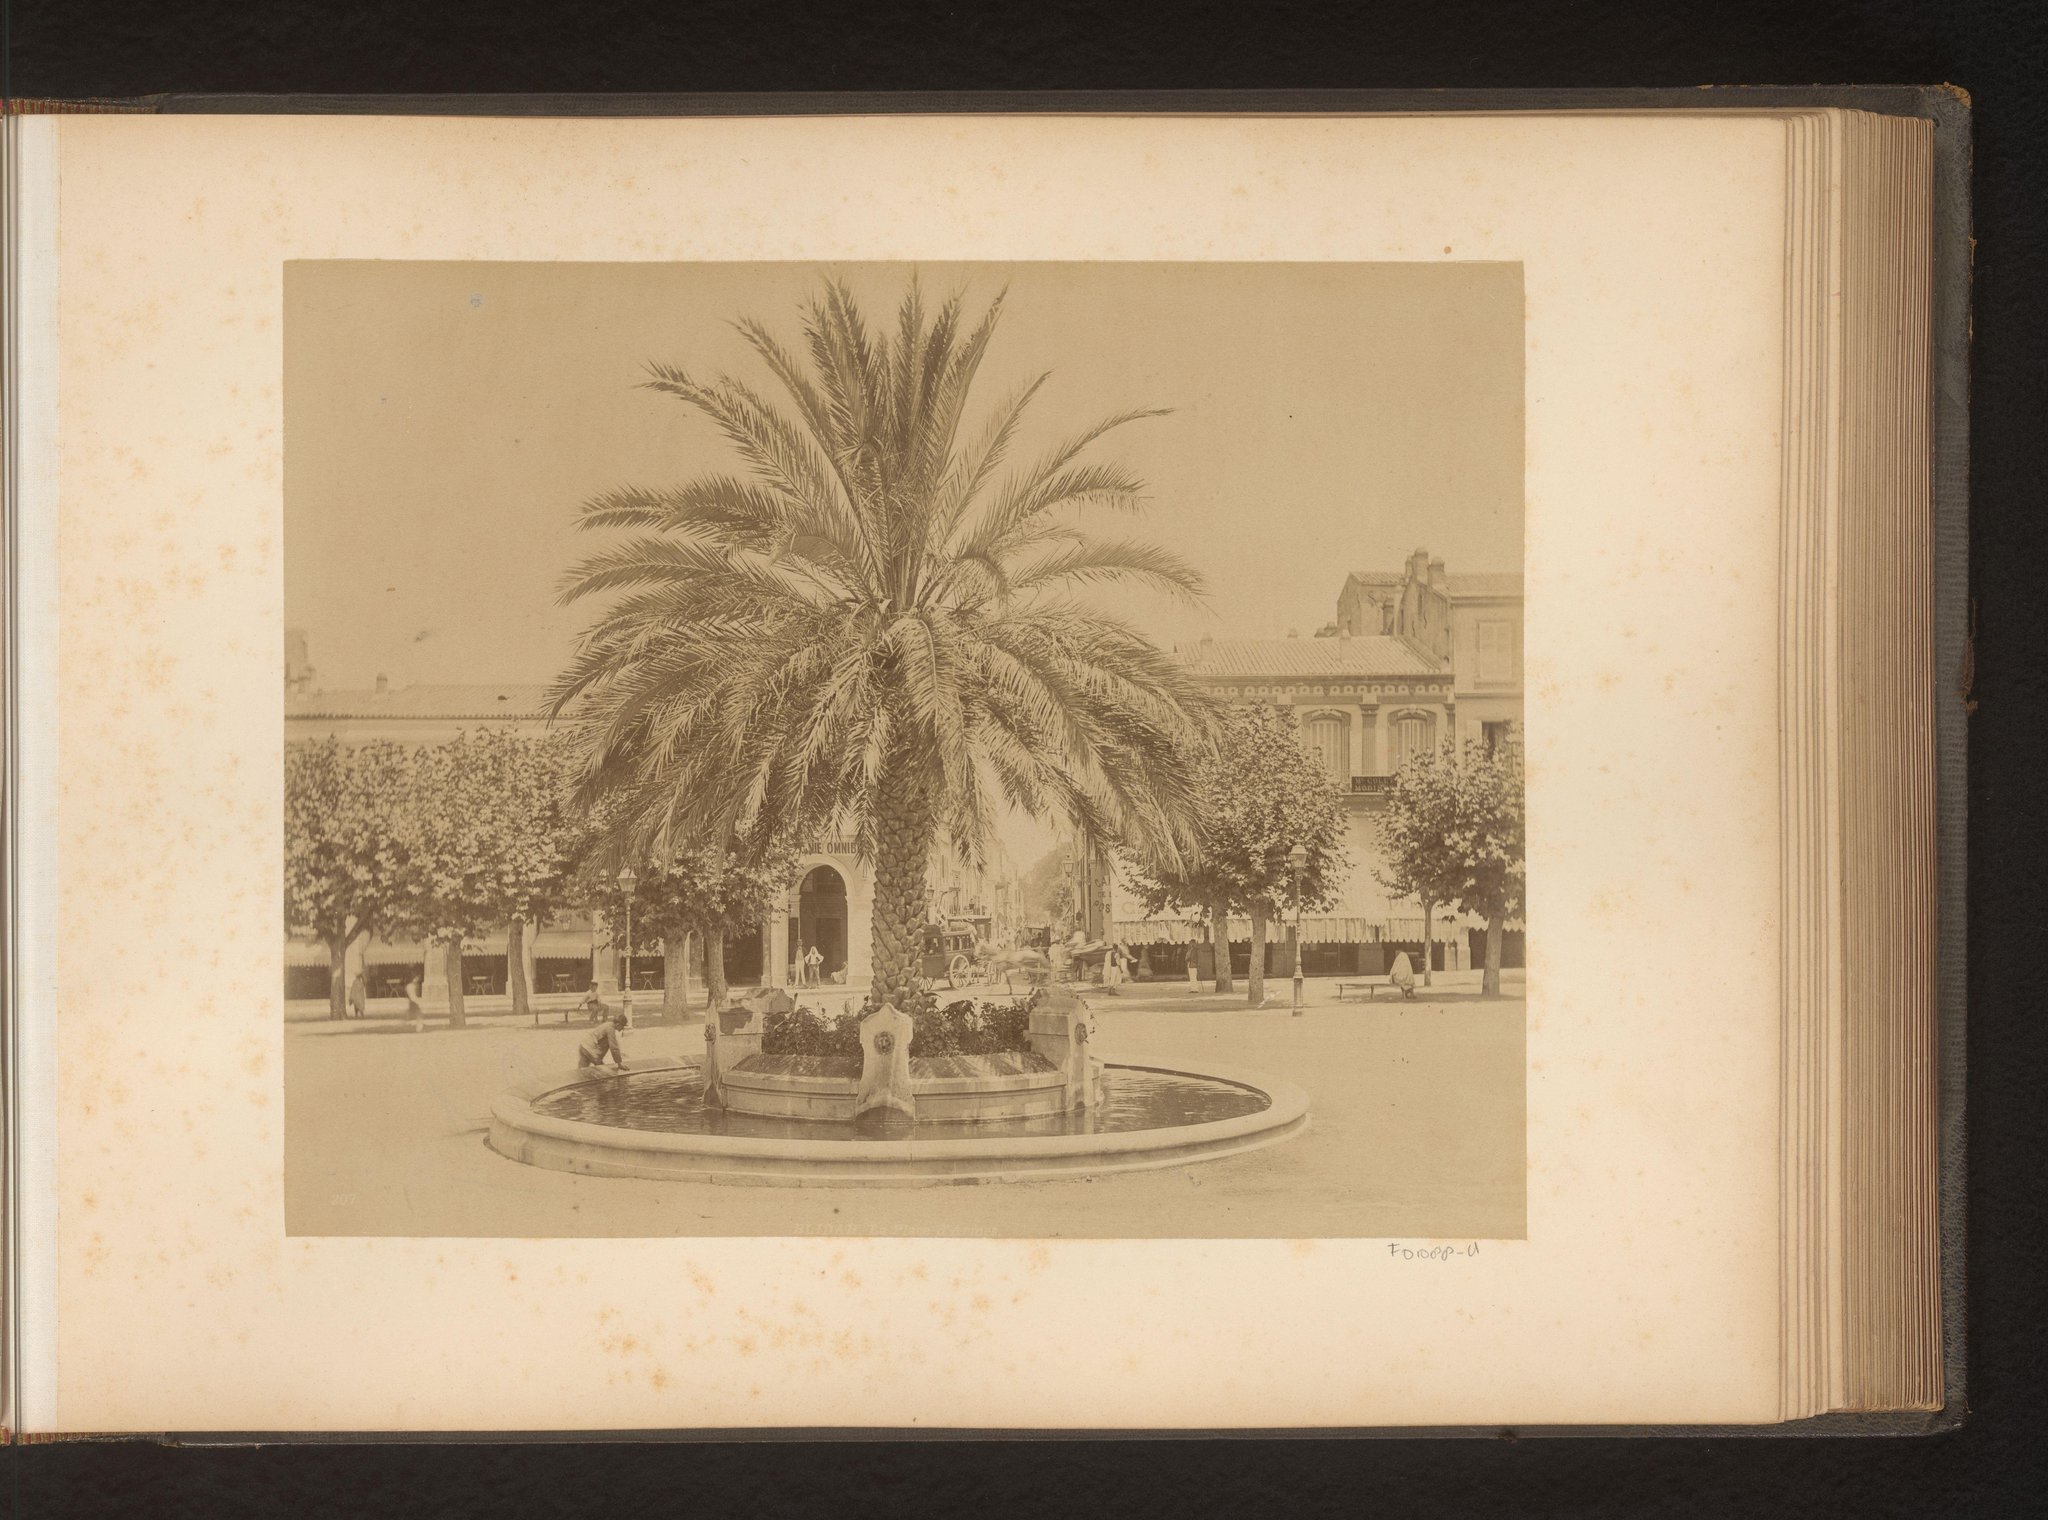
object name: photograph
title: Gezicht op La Place d'Armes te Blida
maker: étienne neurdein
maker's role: publisher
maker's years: 1832-1918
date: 1880-1900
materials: photographic support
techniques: albumen print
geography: el boulaïda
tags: square, place, circus, etc., trees: palm-tree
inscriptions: number: ‘207’